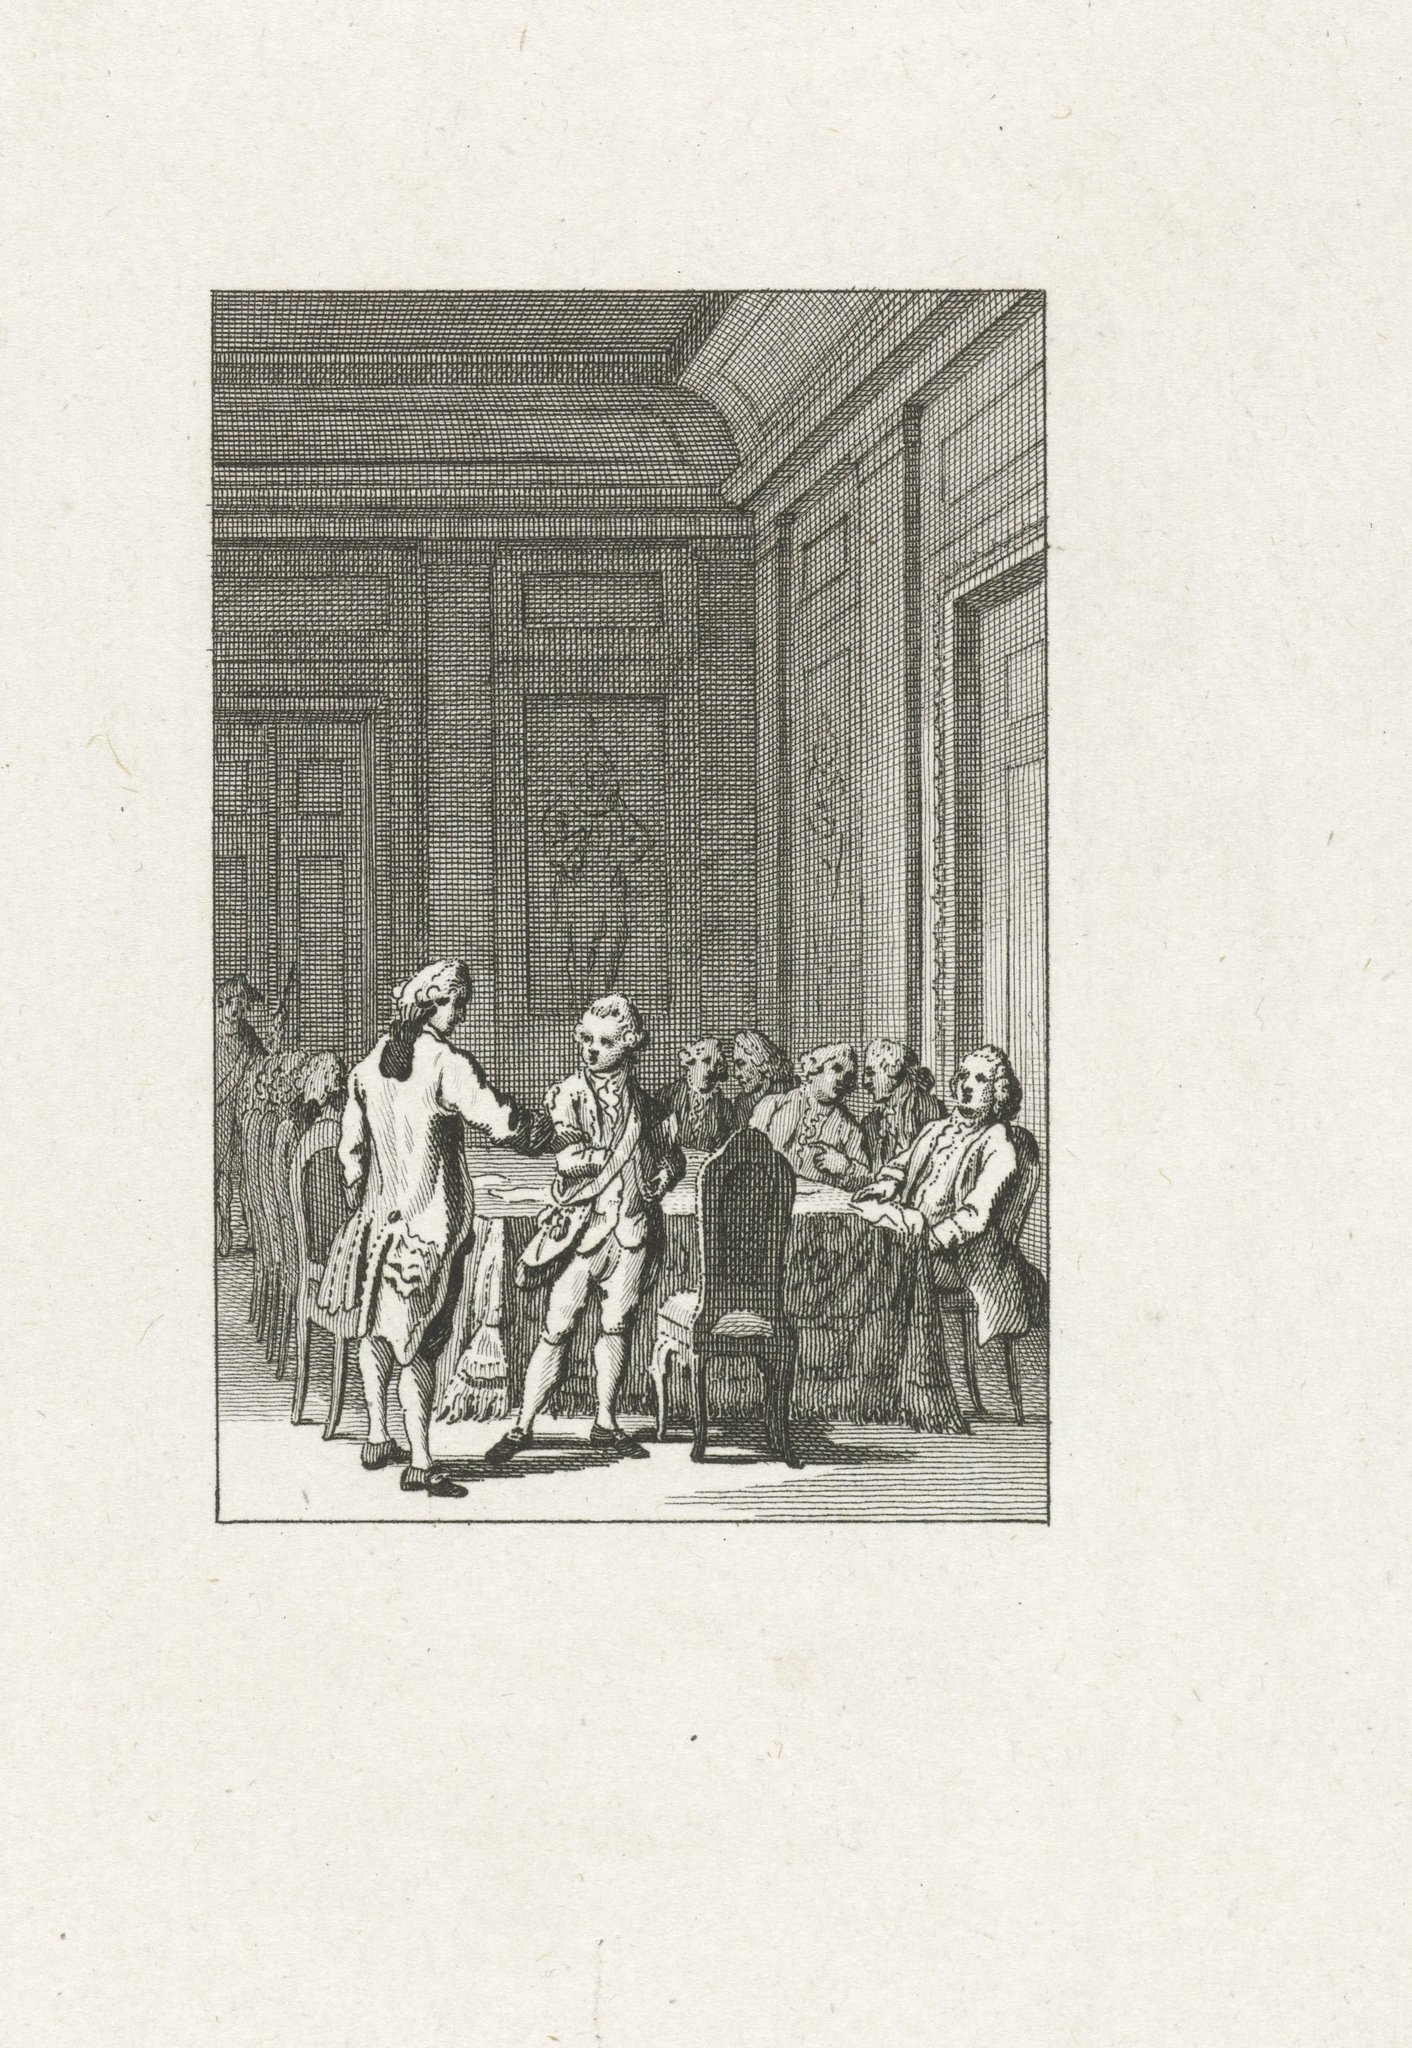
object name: print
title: Installatie van Willem V als erfstadhouder, 1766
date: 1780-1795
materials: paper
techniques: etching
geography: northern netherlands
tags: the hague, william v (prince of orange), installation of a ruler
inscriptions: collector's mark: Lugt 2228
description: Gebruikt als illustratie in: J. Fokke, Geschiedenissen der Vereenigde Nederlanden voor de vaderlandsche jeugd, Johannes Allart, Amsterdam 1783-1795, 25 delen, dl. 12, pl. 10.